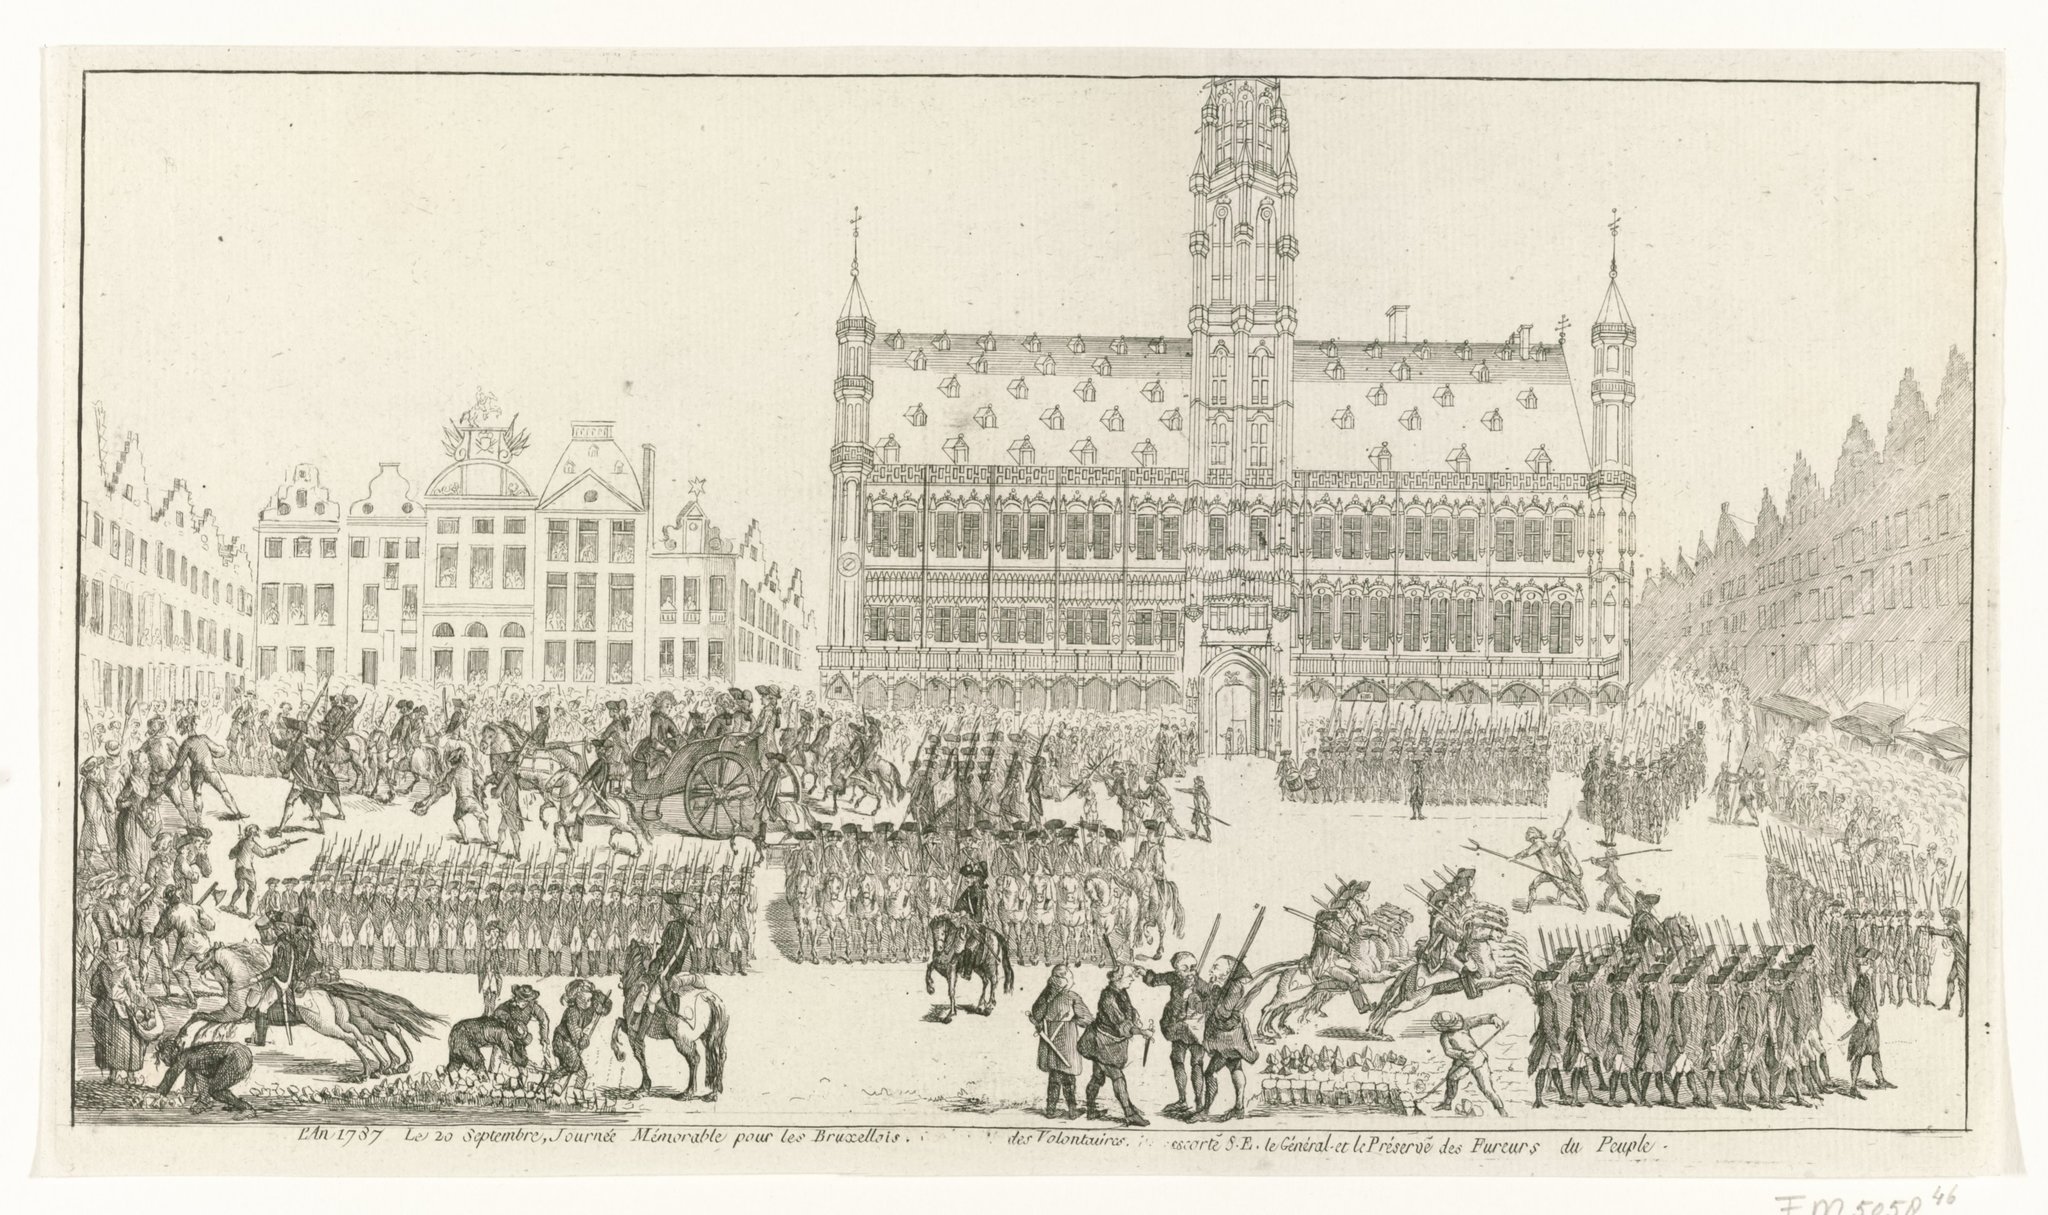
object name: print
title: Generaal d'Alton geëscorteerd door de vrijwilligers te Brussel, 1787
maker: Anonymous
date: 1787-1790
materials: paper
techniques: engraving, etching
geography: southern netherlands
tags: revolution, revolt, brussels, brabant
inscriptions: collector's mark: Lugt 2228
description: Het rijtuig met de Oostenrijkse generaal d'Alton geëscorteerd door de Brabantse vrijwilligers tegen het woedende volk op de Grote Markt te Brussel, 20 september 1787. Onderdeel van een grote groep van prenten betrekking hebbend op de gebeurtenissen van de Brabantse Omwenteling en de periode 1787-1790.